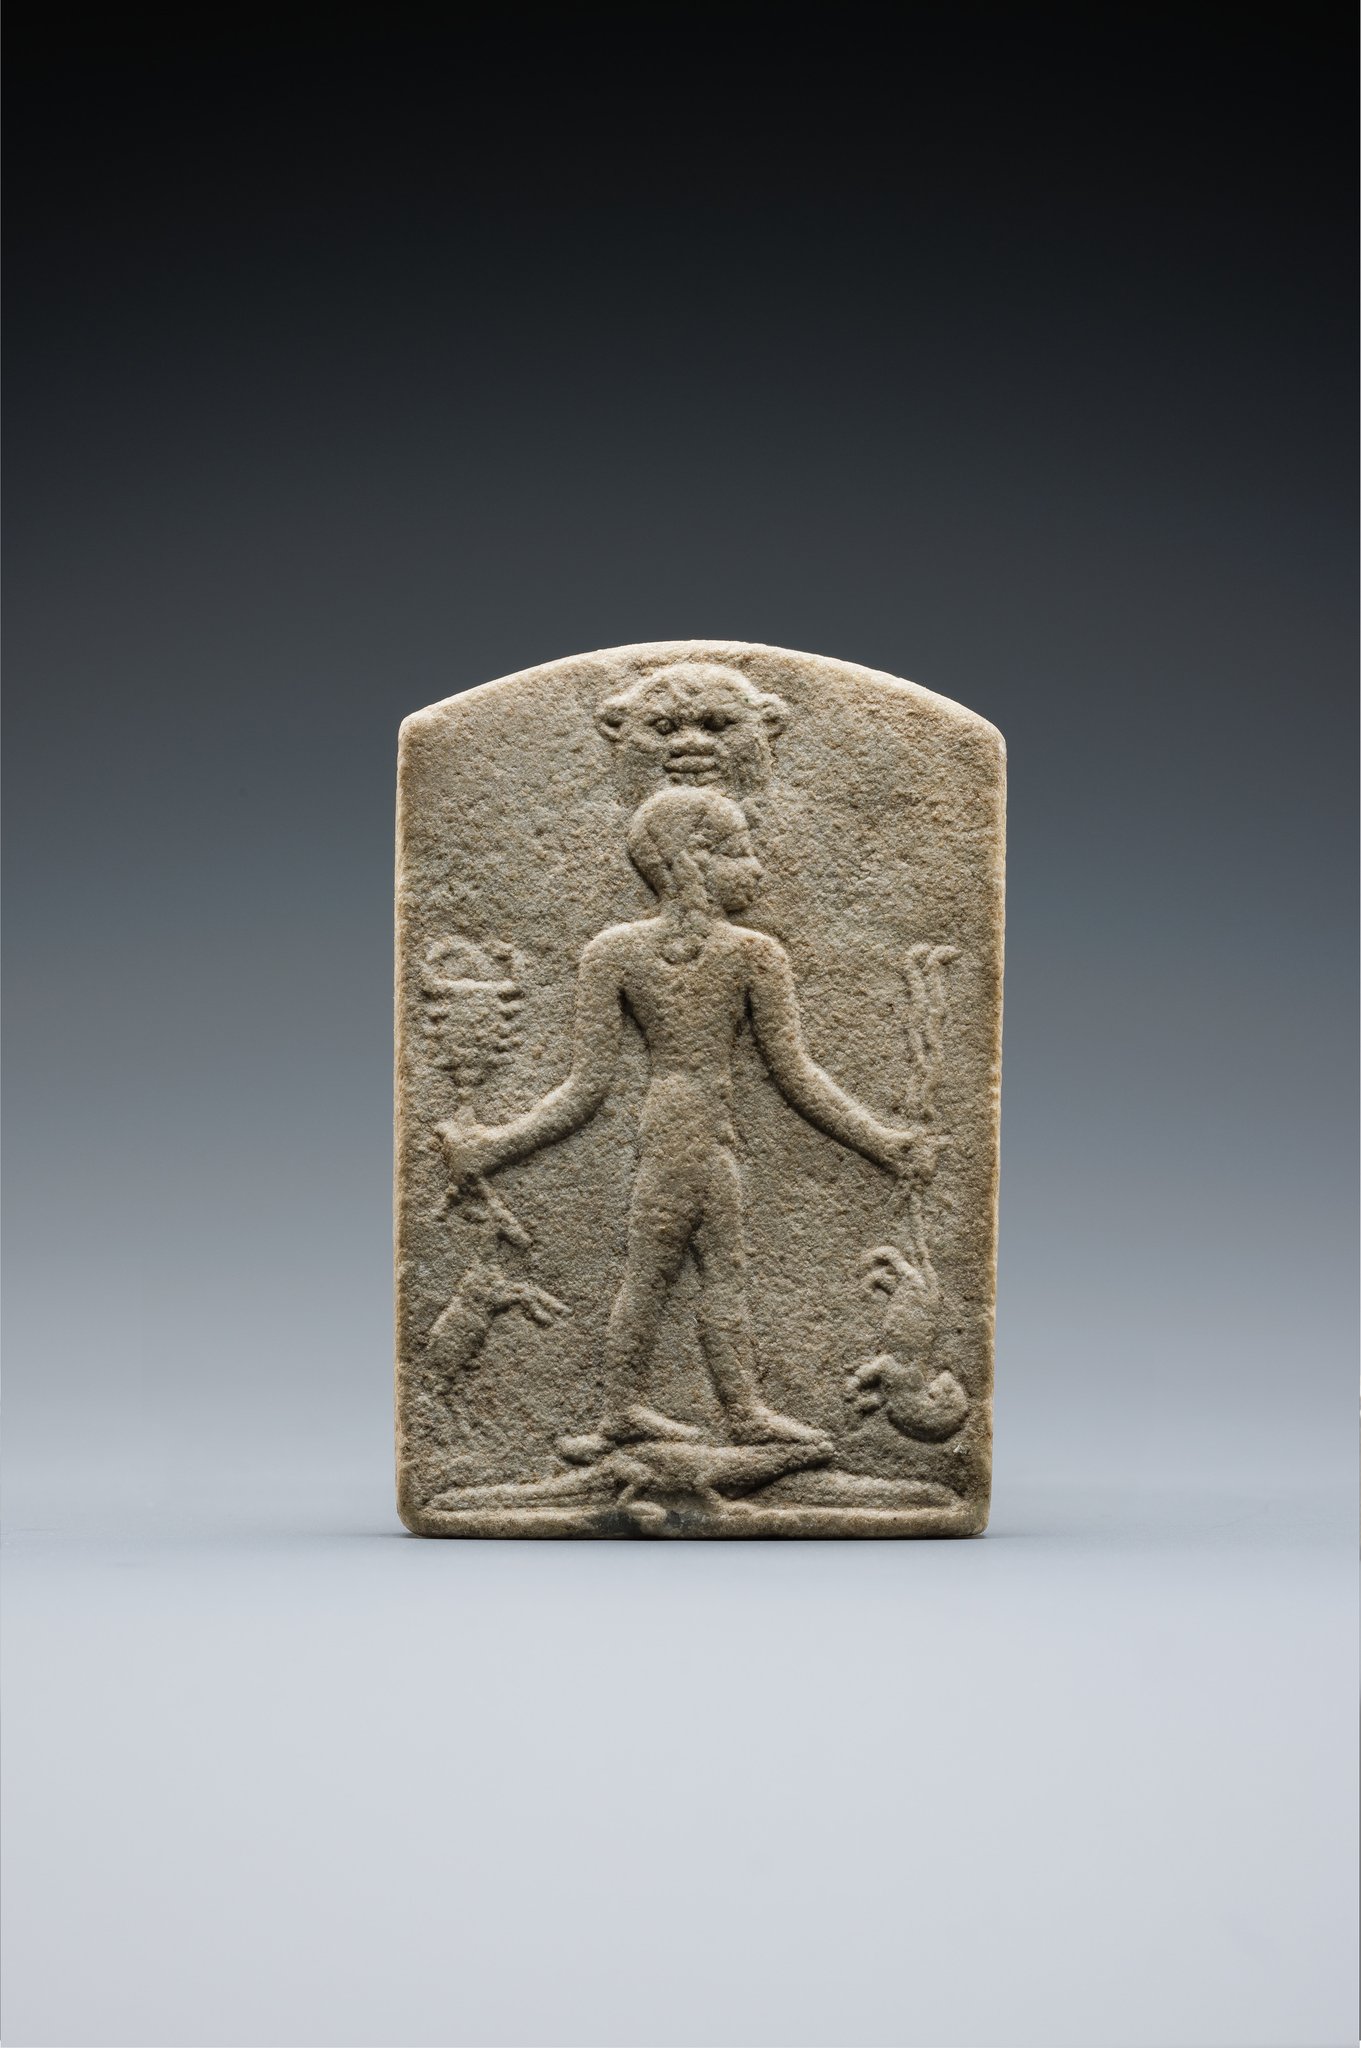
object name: cippus, horus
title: Cippus of Horus (magical stela)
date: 664-380 BCE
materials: marble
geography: egypt